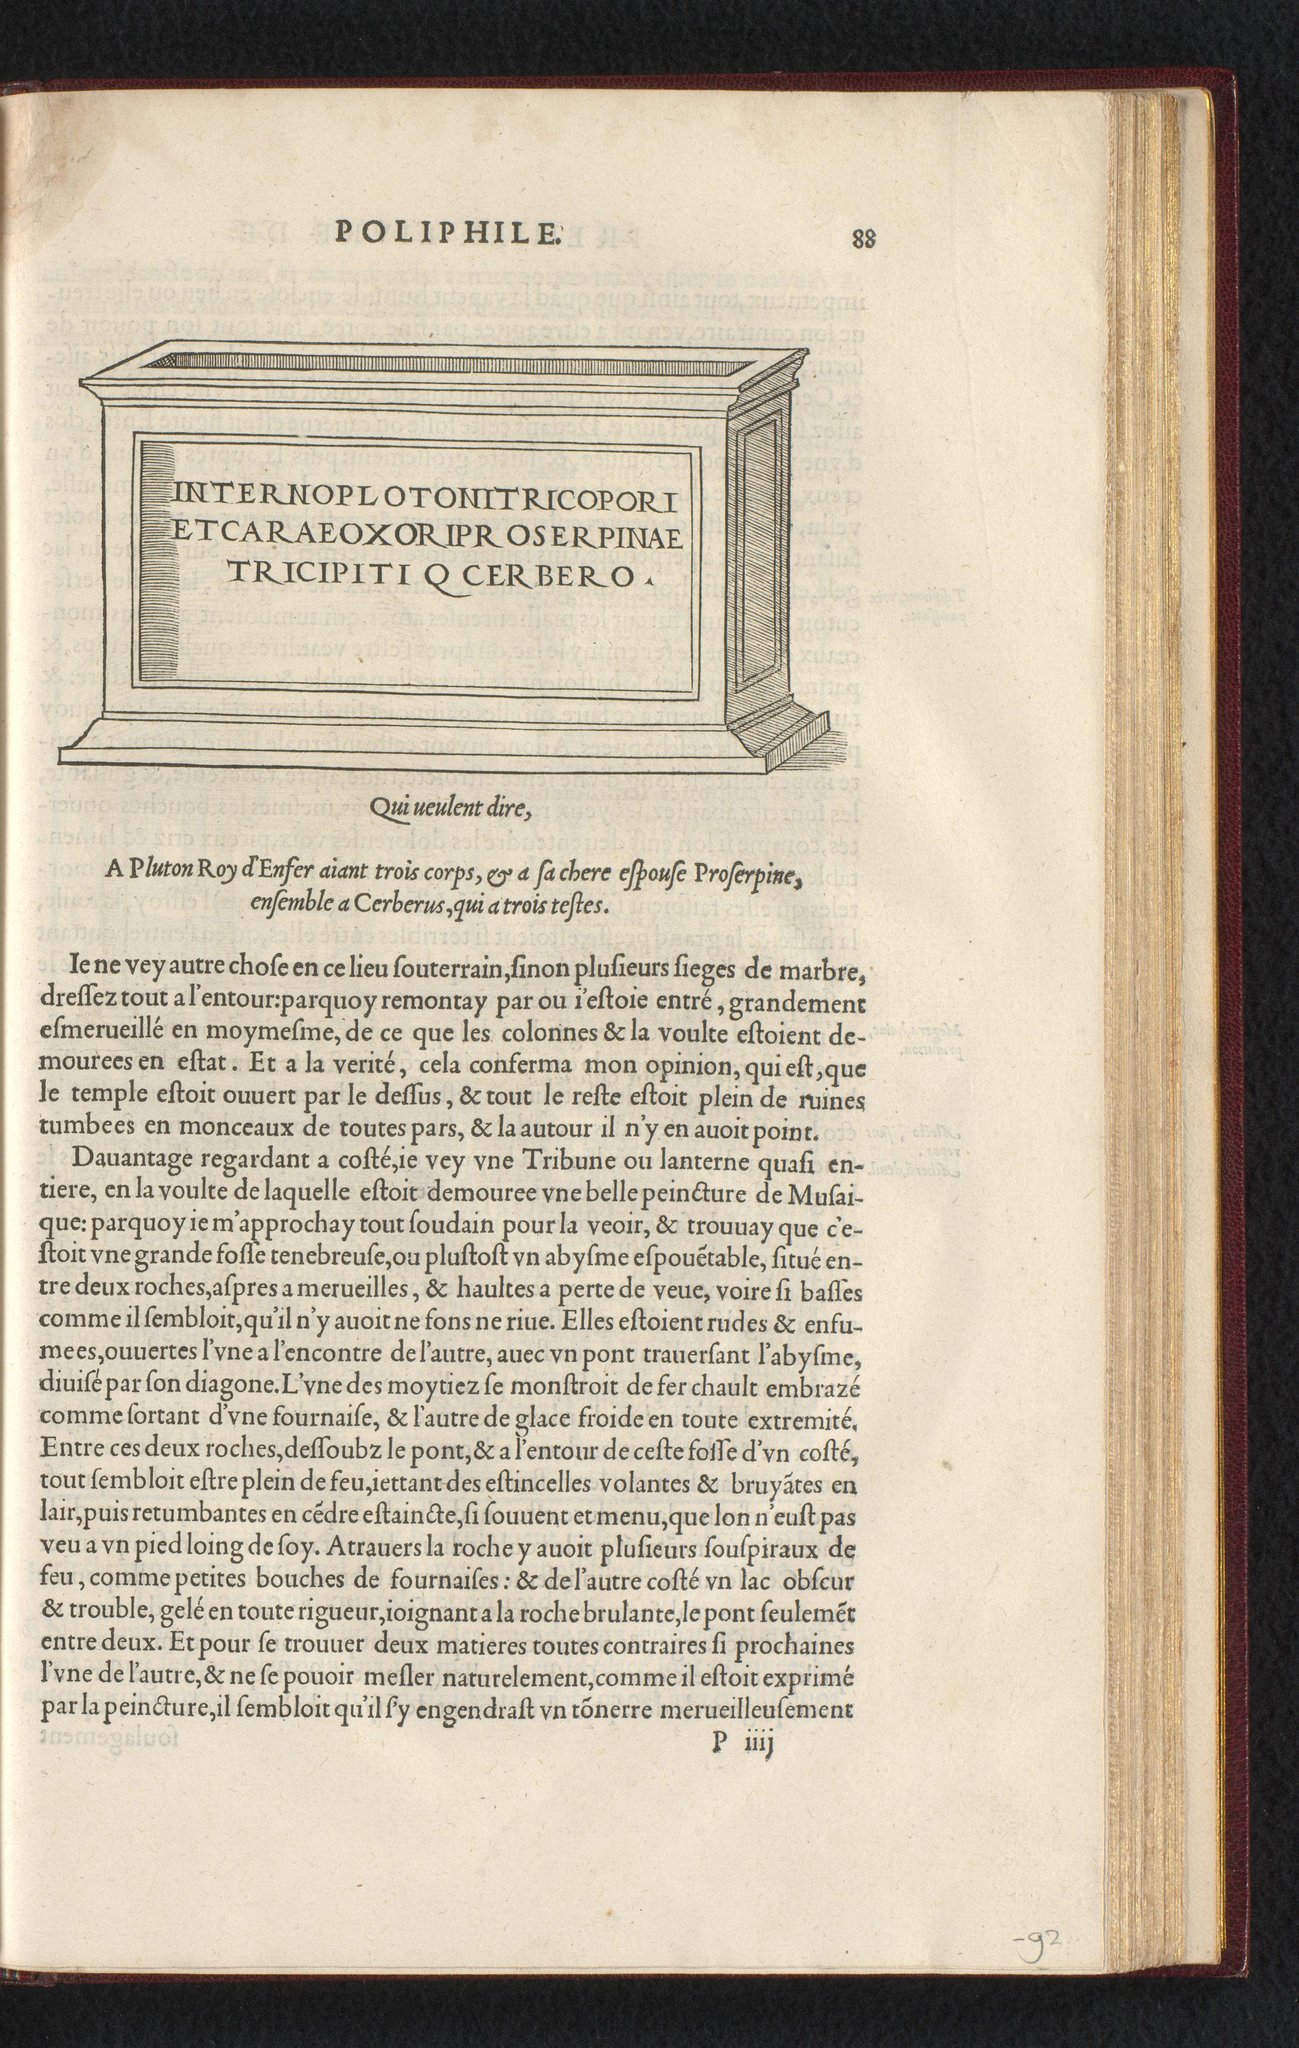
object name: print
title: Sokkel met opschrift aan Pluto, Proserpina en Cerberus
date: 1546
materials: paper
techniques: letterpress printing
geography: paris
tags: (scenes from) specific works of literature: colonna, hypnerotomachia poliphili, pedestal of a piece of sculpture (perhaps in the form of a herm)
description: Prent uit: Colonna, Francesco. Hypnerotomachie ou discours du songe de Poliphile, deduisant comme amour le combat a l'occasion de Polia. Parijs: Jacques Kerver, 1546, recto fol. 88.